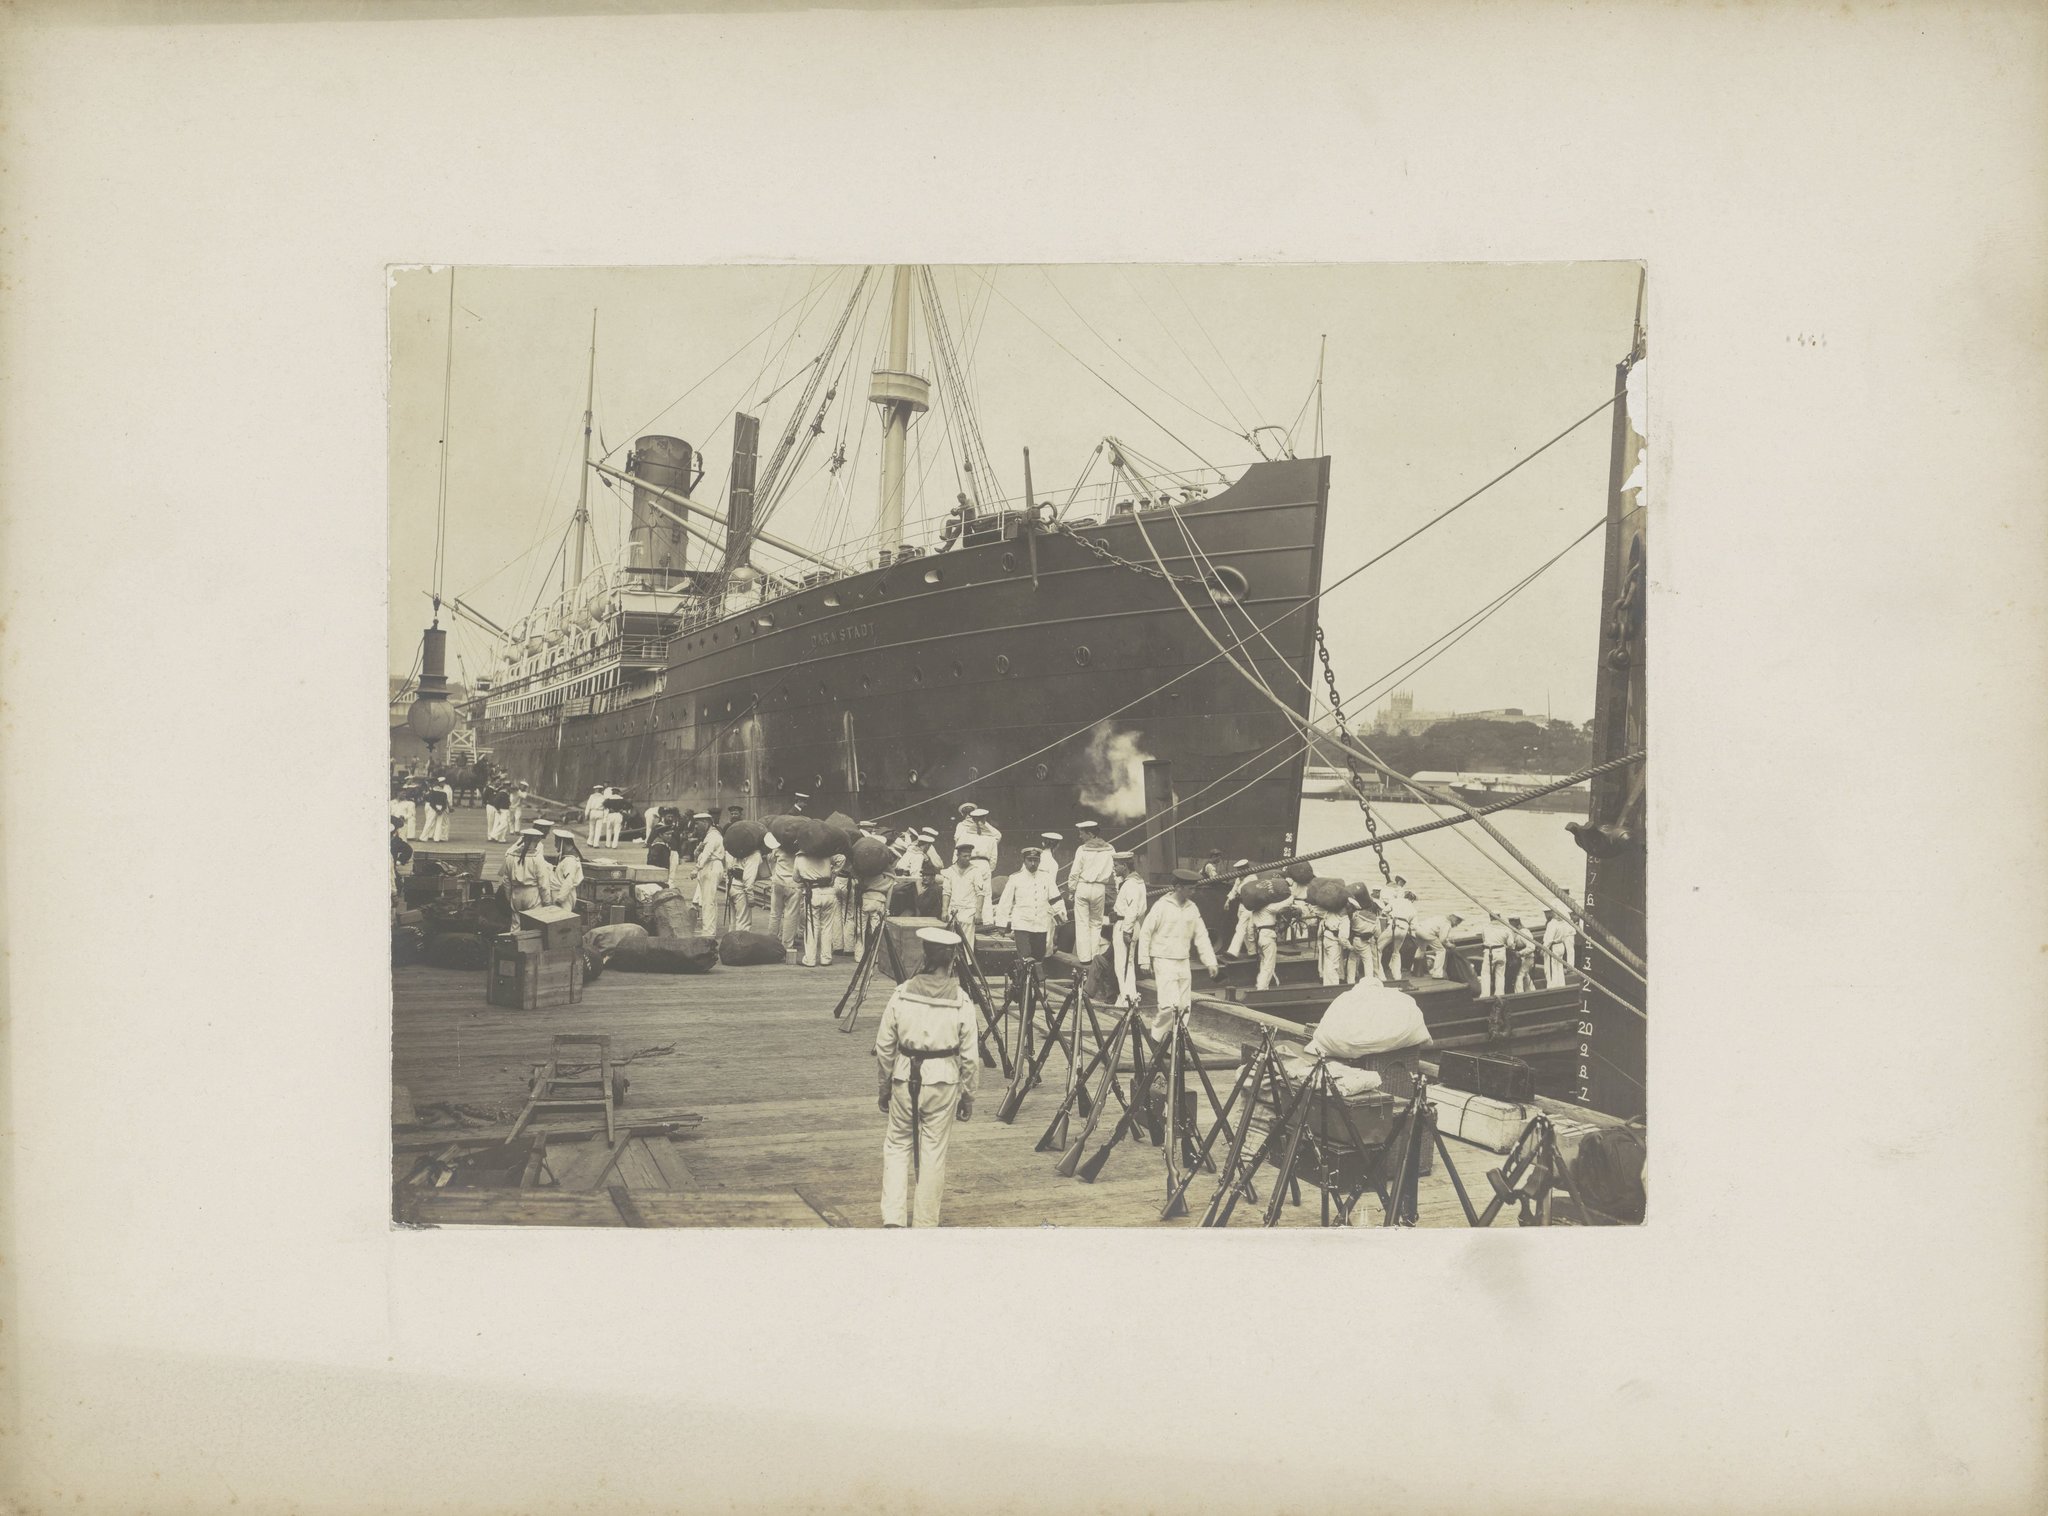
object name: album leaf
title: Kade in (vermoedelijk) Sydney met stoomboot 'Darmstadt', mariniers, bagage en geweren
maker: Anonymous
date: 1890-1910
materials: cardboard, paper, photographic support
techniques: gelatin silver print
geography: sydney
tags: sailor (+ weapons), quay (+ city(-scape) with figures, staffage), steamship, motorship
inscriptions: inscription: ‘uit map met foto's van Sydney gekocht Waterlooplein Amsterdam 1963 à f 0,10’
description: Onderdeel van Reisalbum met foto's van bezienswaardigheden in Sydney.